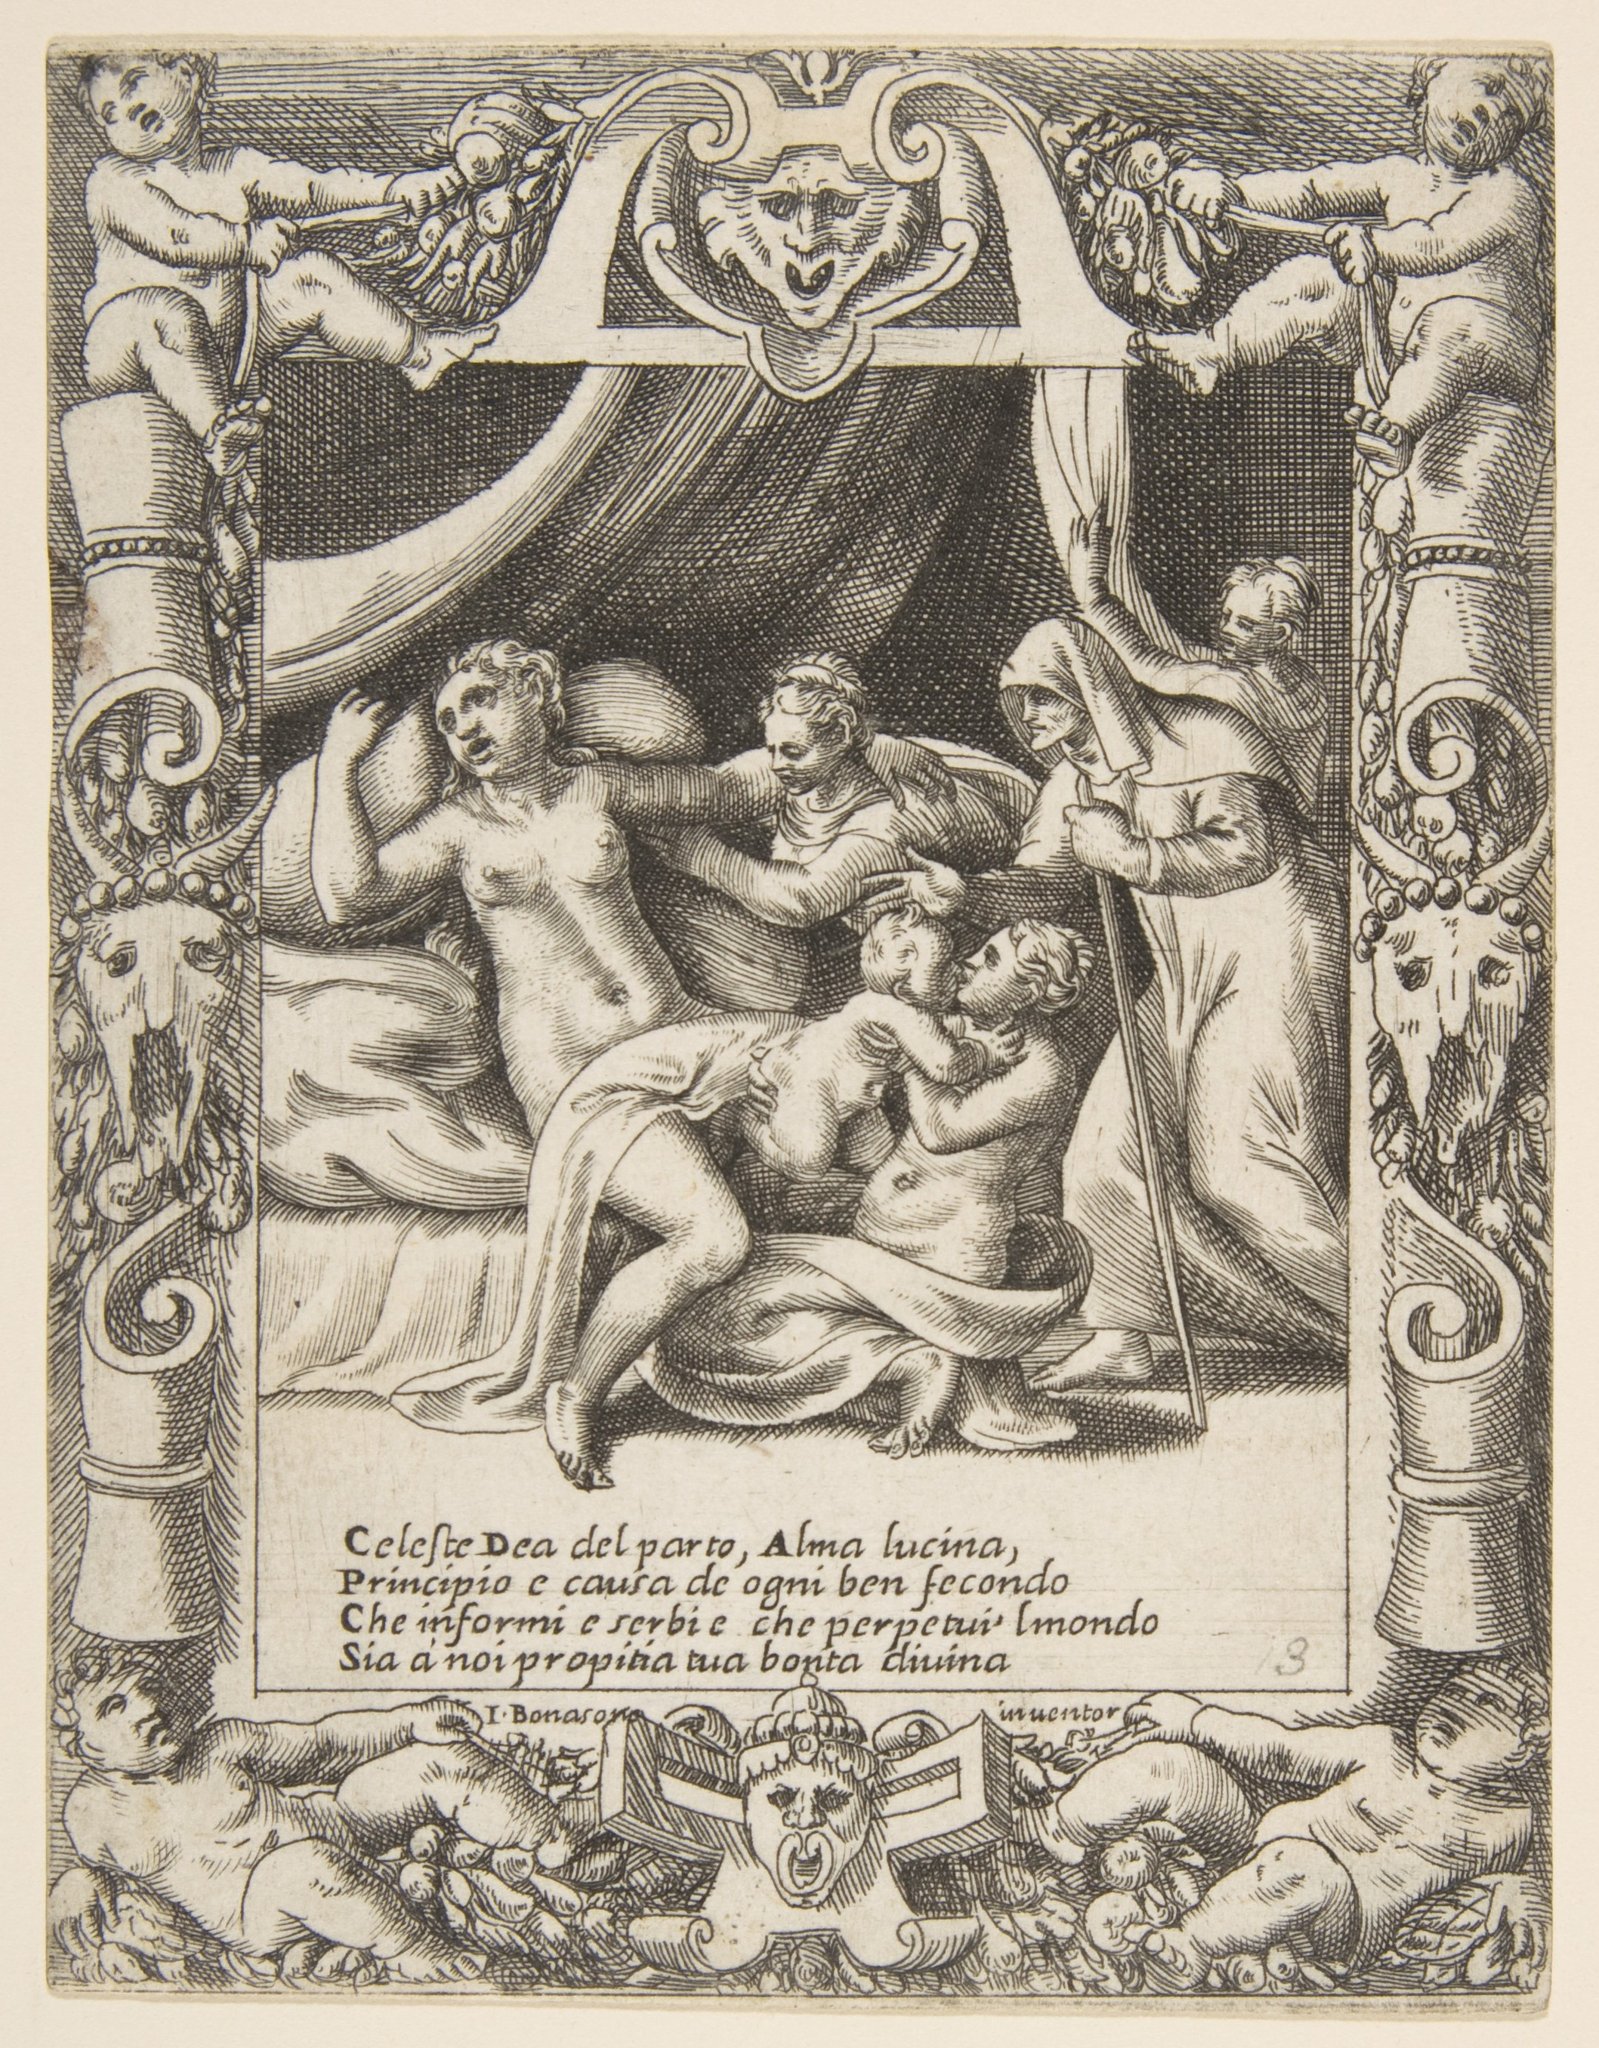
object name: print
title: A woman in labor imploring the aid of Lucina set within a decorative cartouche, from "Loves, Rages and Jealousies of Juno"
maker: giulio bonasone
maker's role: artist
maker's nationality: italian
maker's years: 1510-1576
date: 1531-1576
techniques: engraving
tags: children,infants,women